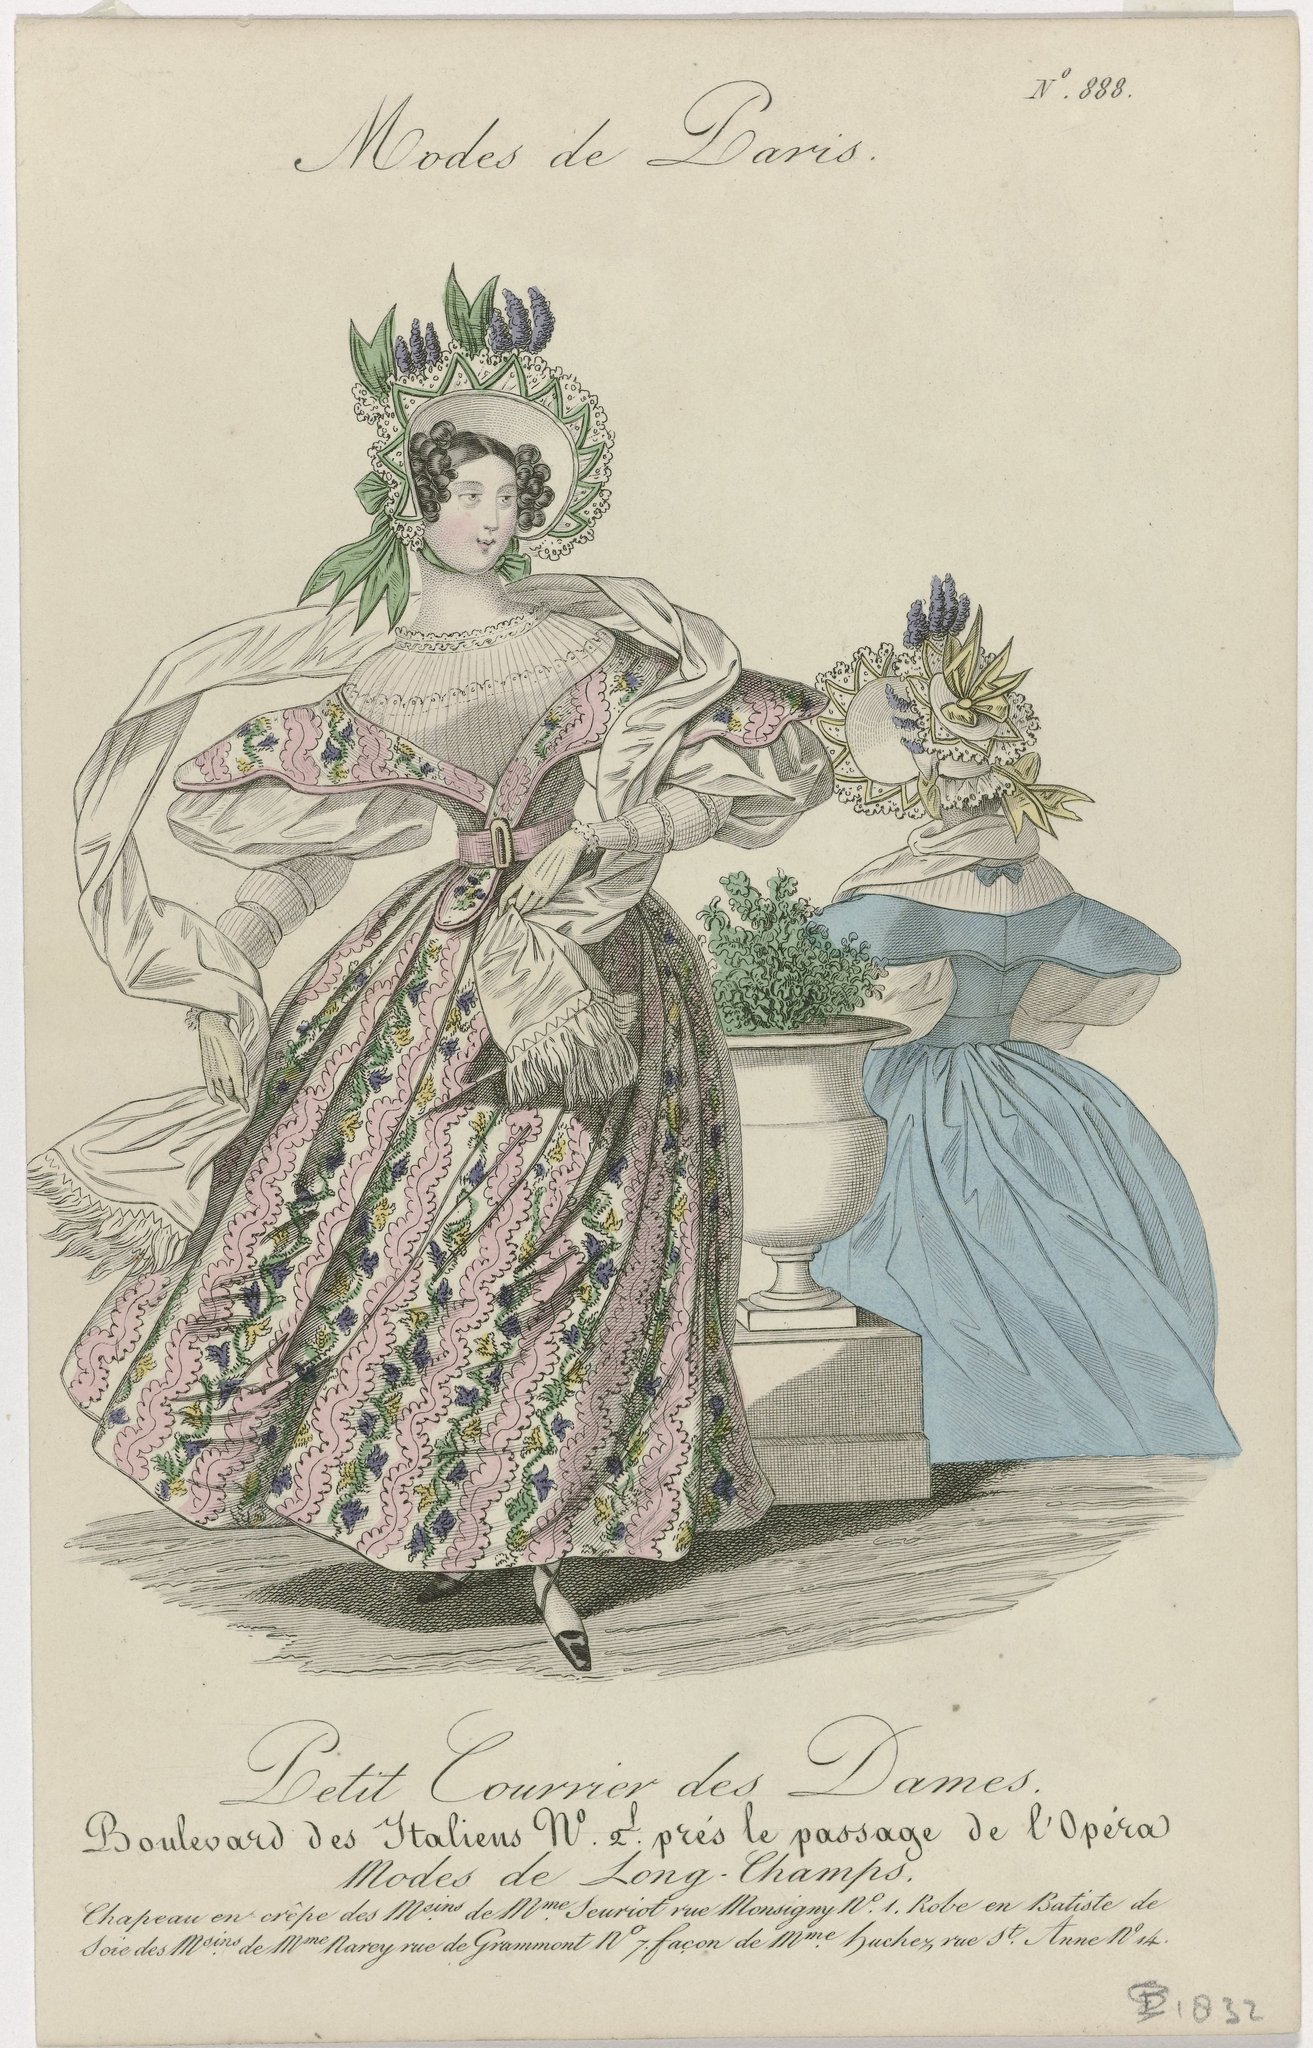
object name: fashion print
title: Petit Courrier des Dames, 1832, No. 888 : Chapeau en crêp (...)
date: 1832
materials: paper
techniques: engraving, hand coloring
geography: paris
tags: clothing for the upper part of the body (shawl) (+ women's clothes), head-gear (+ women's clothes), fashion plates, gloves, mittens, etc. (+ women's clothes), dress, gown (+ women's clothes), shoes, sandals, belt, girdle, waistband (+ women's clothes)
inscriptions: title: ‘Modes de Paris.’, address: ‘Boulevard des Italiens No.2 près le passage de l'Opèra.’, title: ‘Petit Courrier des Dames.’, caption: ‘Modes de Long-Champs / Chapeau en crêpe des M.sins de M.me Seuriot rue Monsigny No.1. Robe en Batiste de soie des M.sins de M.me Narey rue de Grammont No. 7. façon de M.me Huchez rue St. Anne No. 14.’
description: Hoed van crêpe uit de winkels van M. me Seuriot. Japon van 'batiste de soie' uit de winkels van Narey en uitgevoerd op de manier van Mme Huchez. Verdere accessoires: sjaal afgezet met franjes, ceintuur met gesp, handschoenen, schoenen met gekruiste banden en vierkante neuzen (cothurnes). Prent uit het modetijdschrift Petit Courrier des Dames (1821-1868).